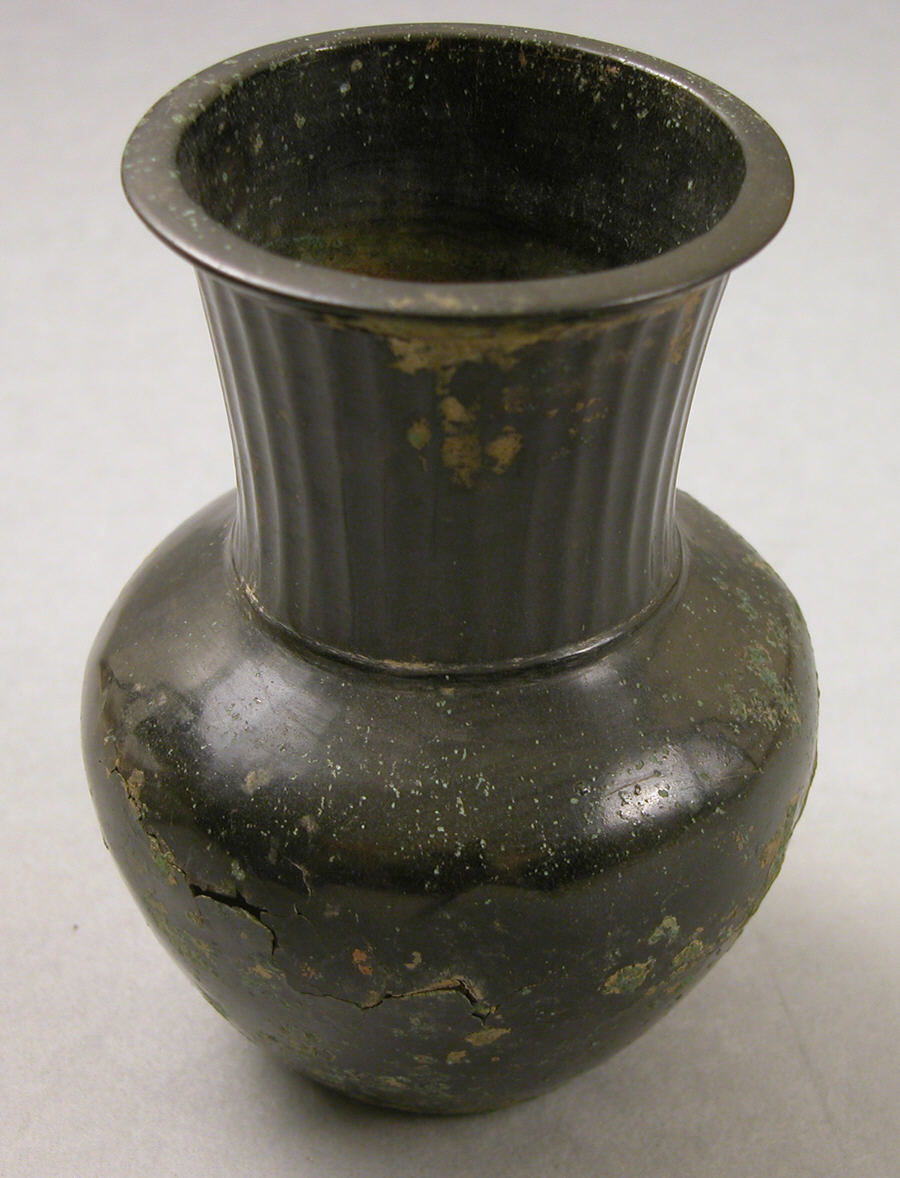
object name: vase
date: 601-800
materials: bronze, tin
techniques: hammering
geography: iran